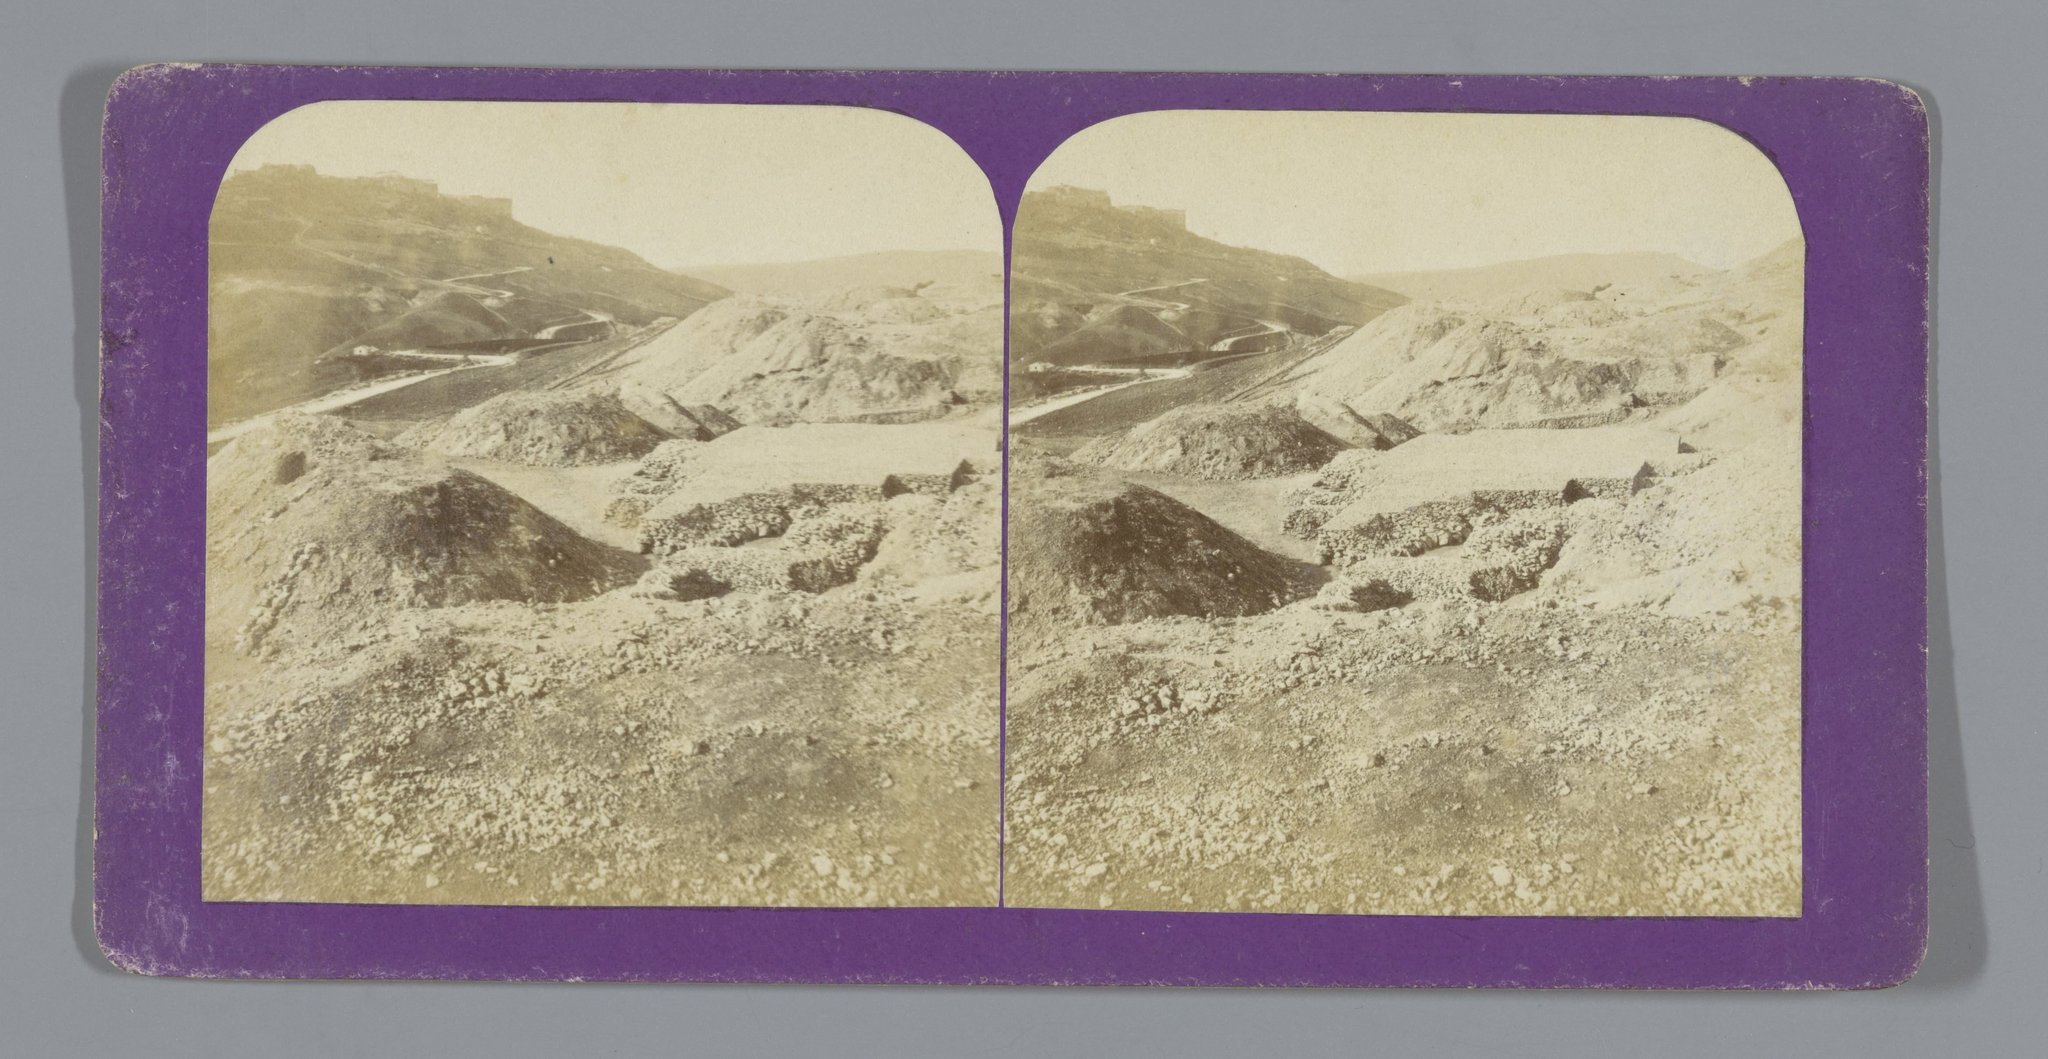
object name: stereograph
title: Mines de Souffre (Girgenti)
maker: jean andrieu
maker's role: fotograaf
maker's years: 1816-1872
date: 1862-1876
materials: cardboard, paper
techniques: albumen print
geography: agrigento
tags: mining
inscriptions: title: ‘1312 Mines de souffre (Girgenti)’